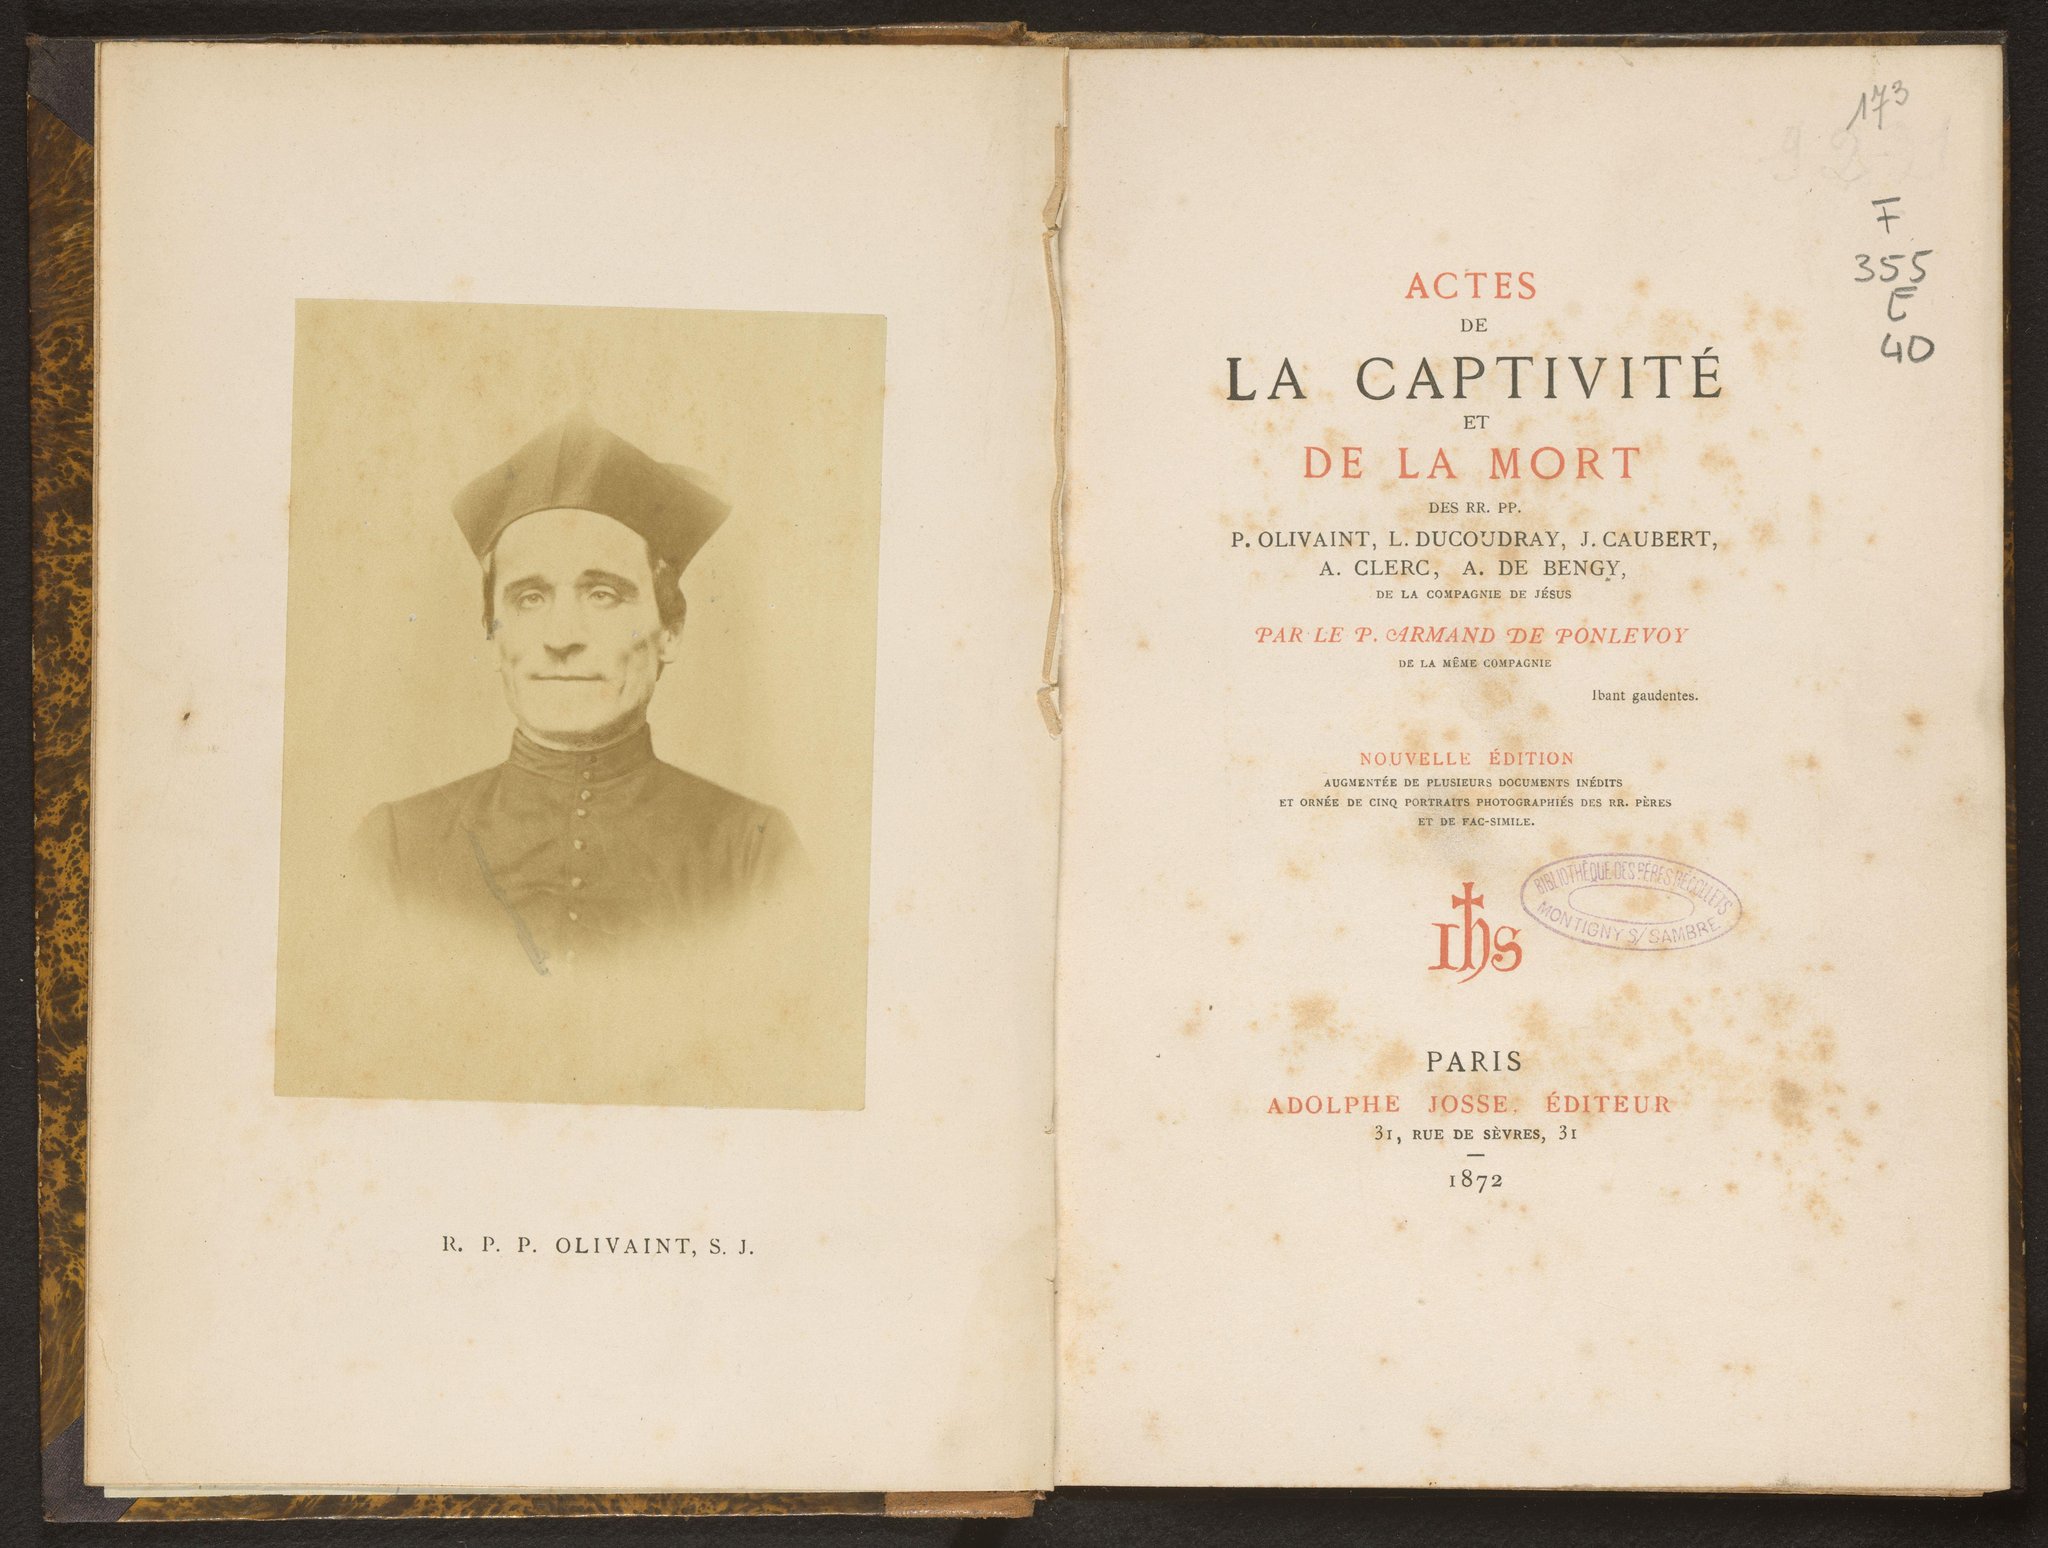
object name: photograph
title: Portret van Pierre Olivaint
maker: Anonymous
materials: photographic support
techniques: albumen print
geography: france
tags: monk(s), friar(s)